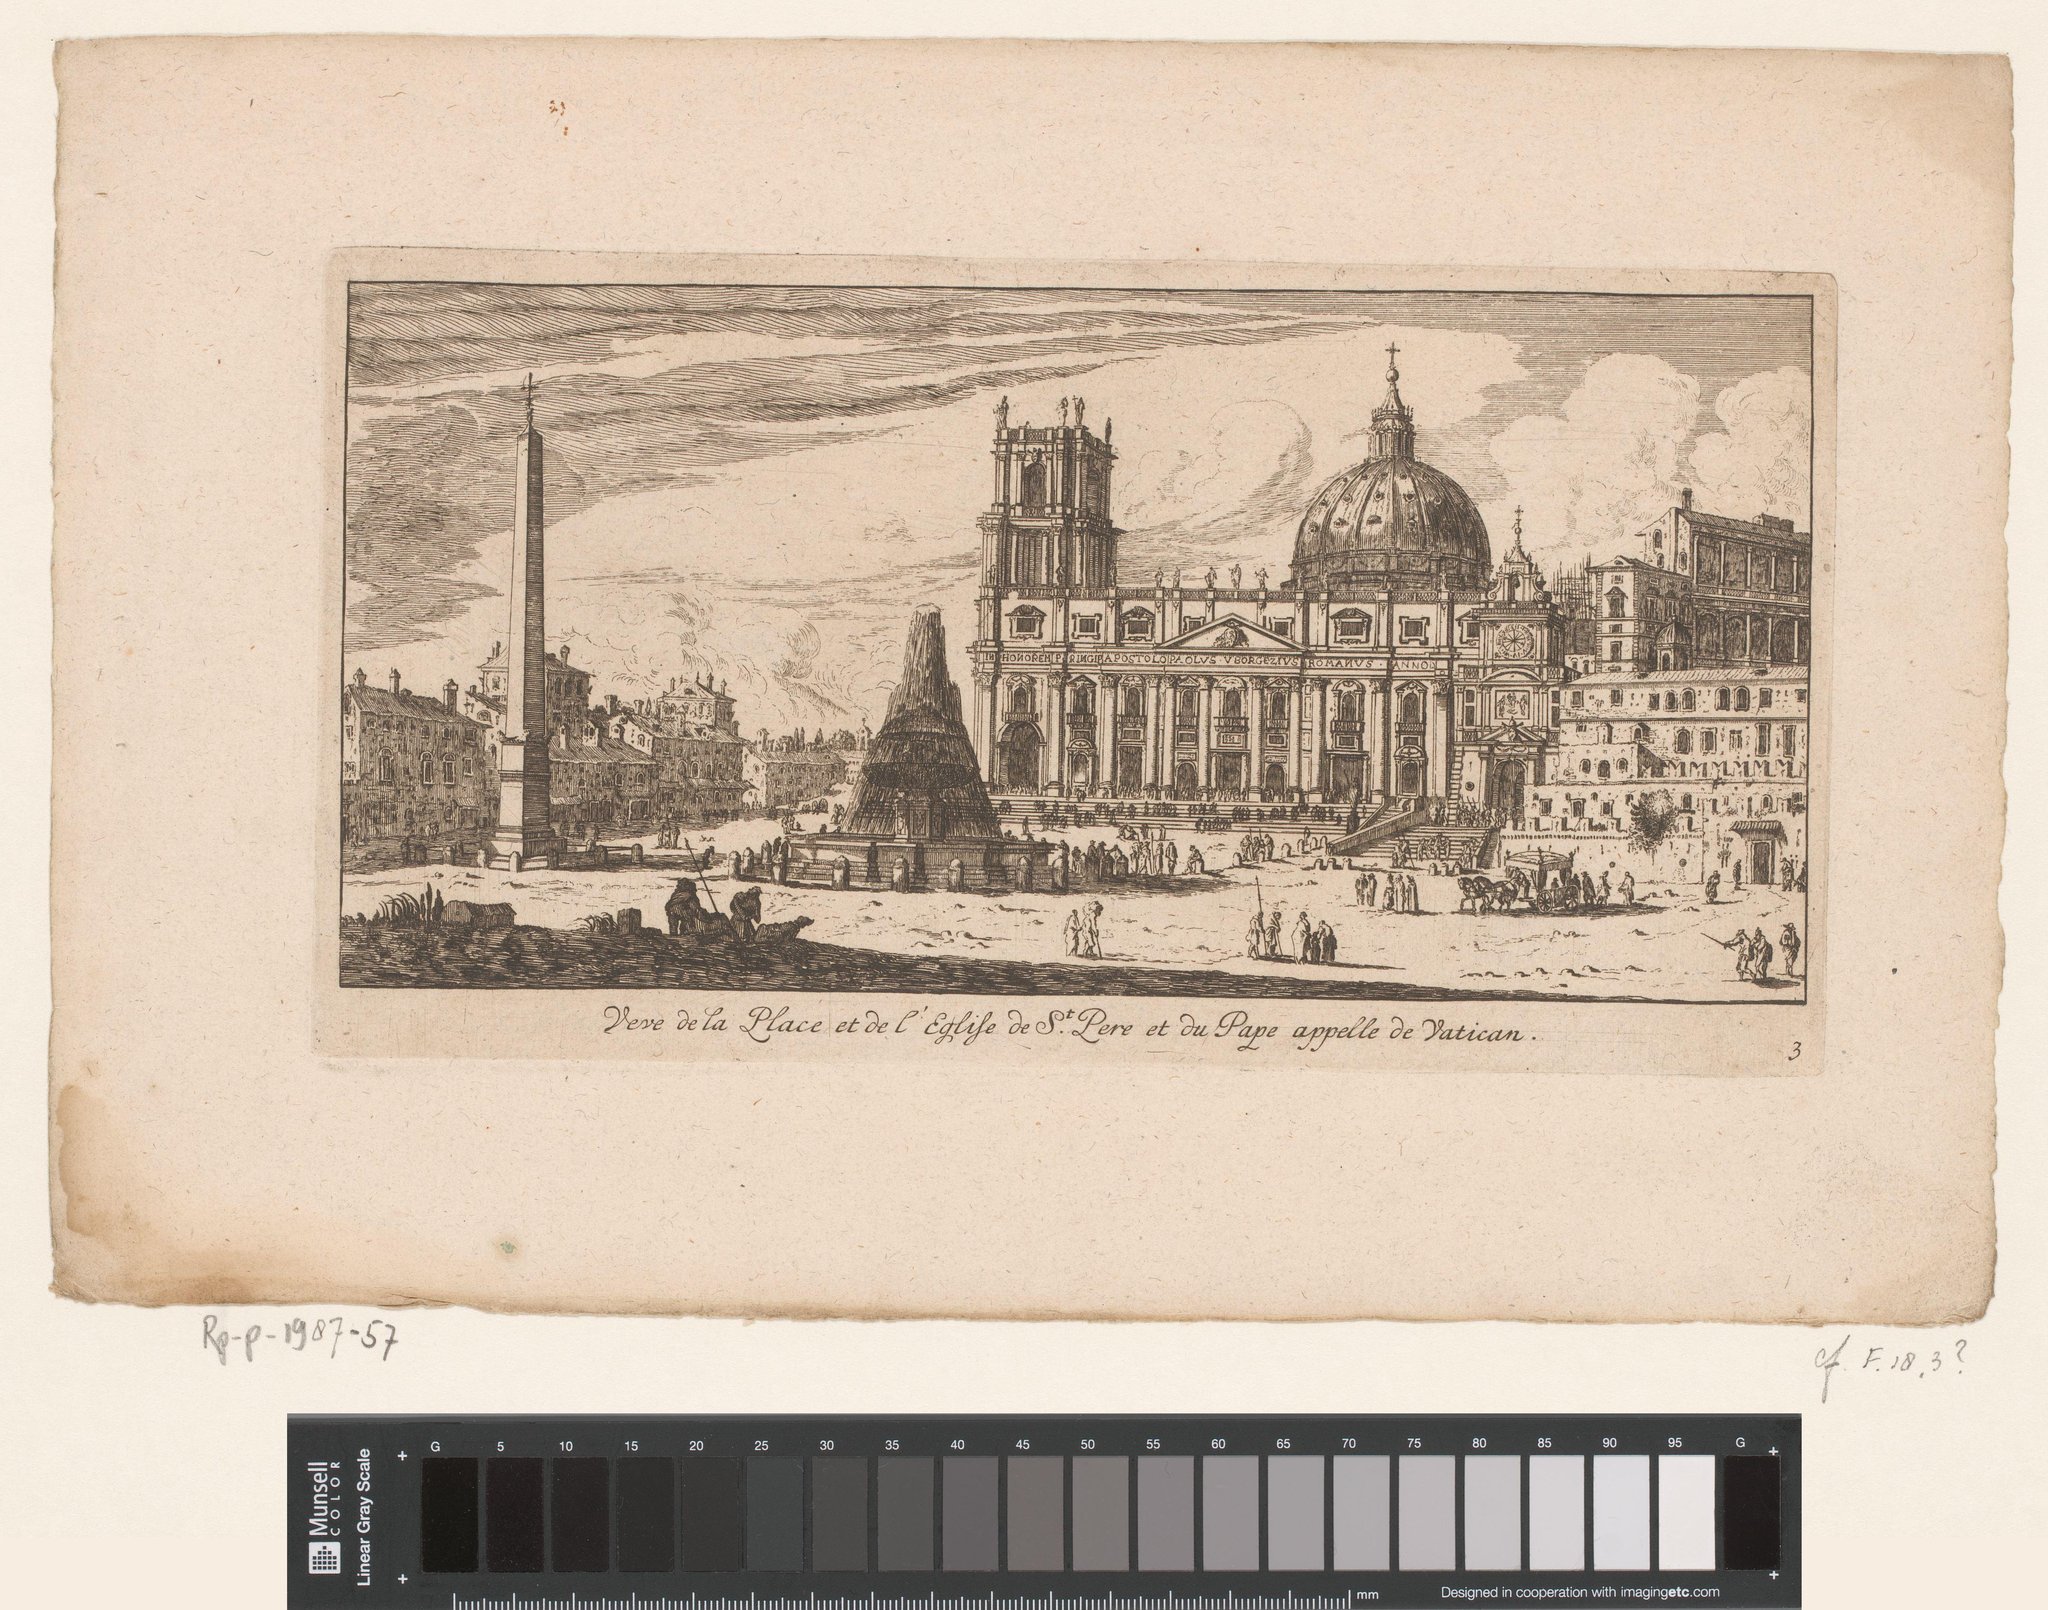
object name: print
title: Gezicht op de Sint-Pietersbasiliek en het Sint-Pietersplein, te Vaticaanstad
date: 1648-1712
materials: paper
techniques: engraving, etching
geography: amsterdam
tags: square, place, circus, etc., church (exterior)